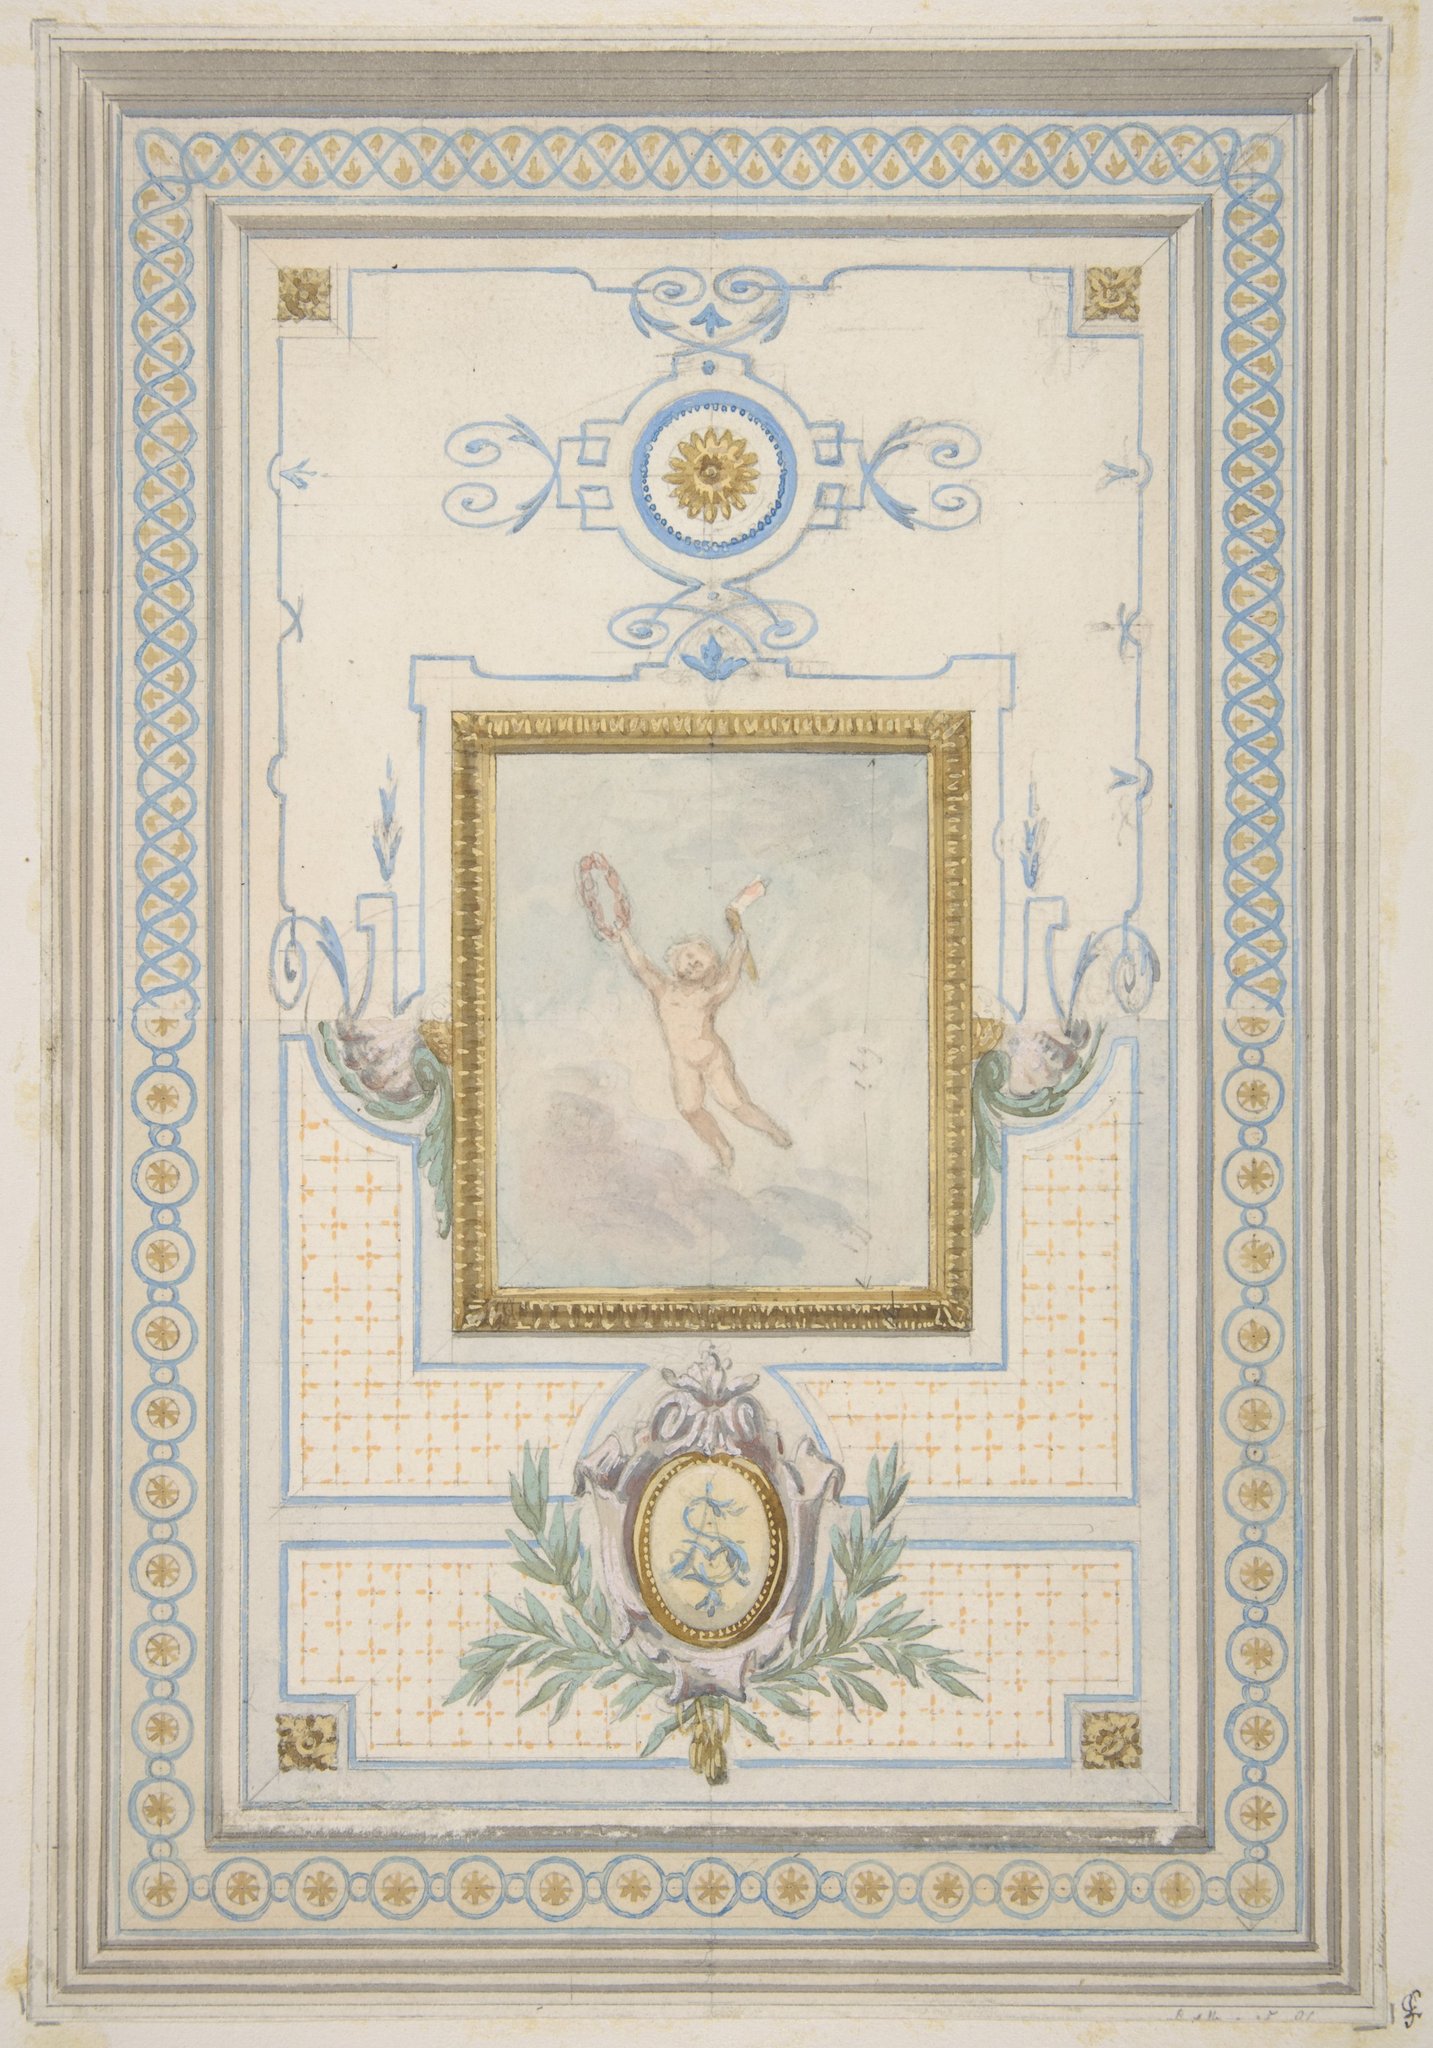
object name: drawing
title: Design for the painted decoration of a ceiling with the monogram: AS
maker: jules-edmond-charles lachaise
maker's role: artist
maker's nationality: french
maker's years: 1897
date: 1830-1897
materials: graphite, ink, watercolor, paper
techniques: pen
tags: architecture,putti